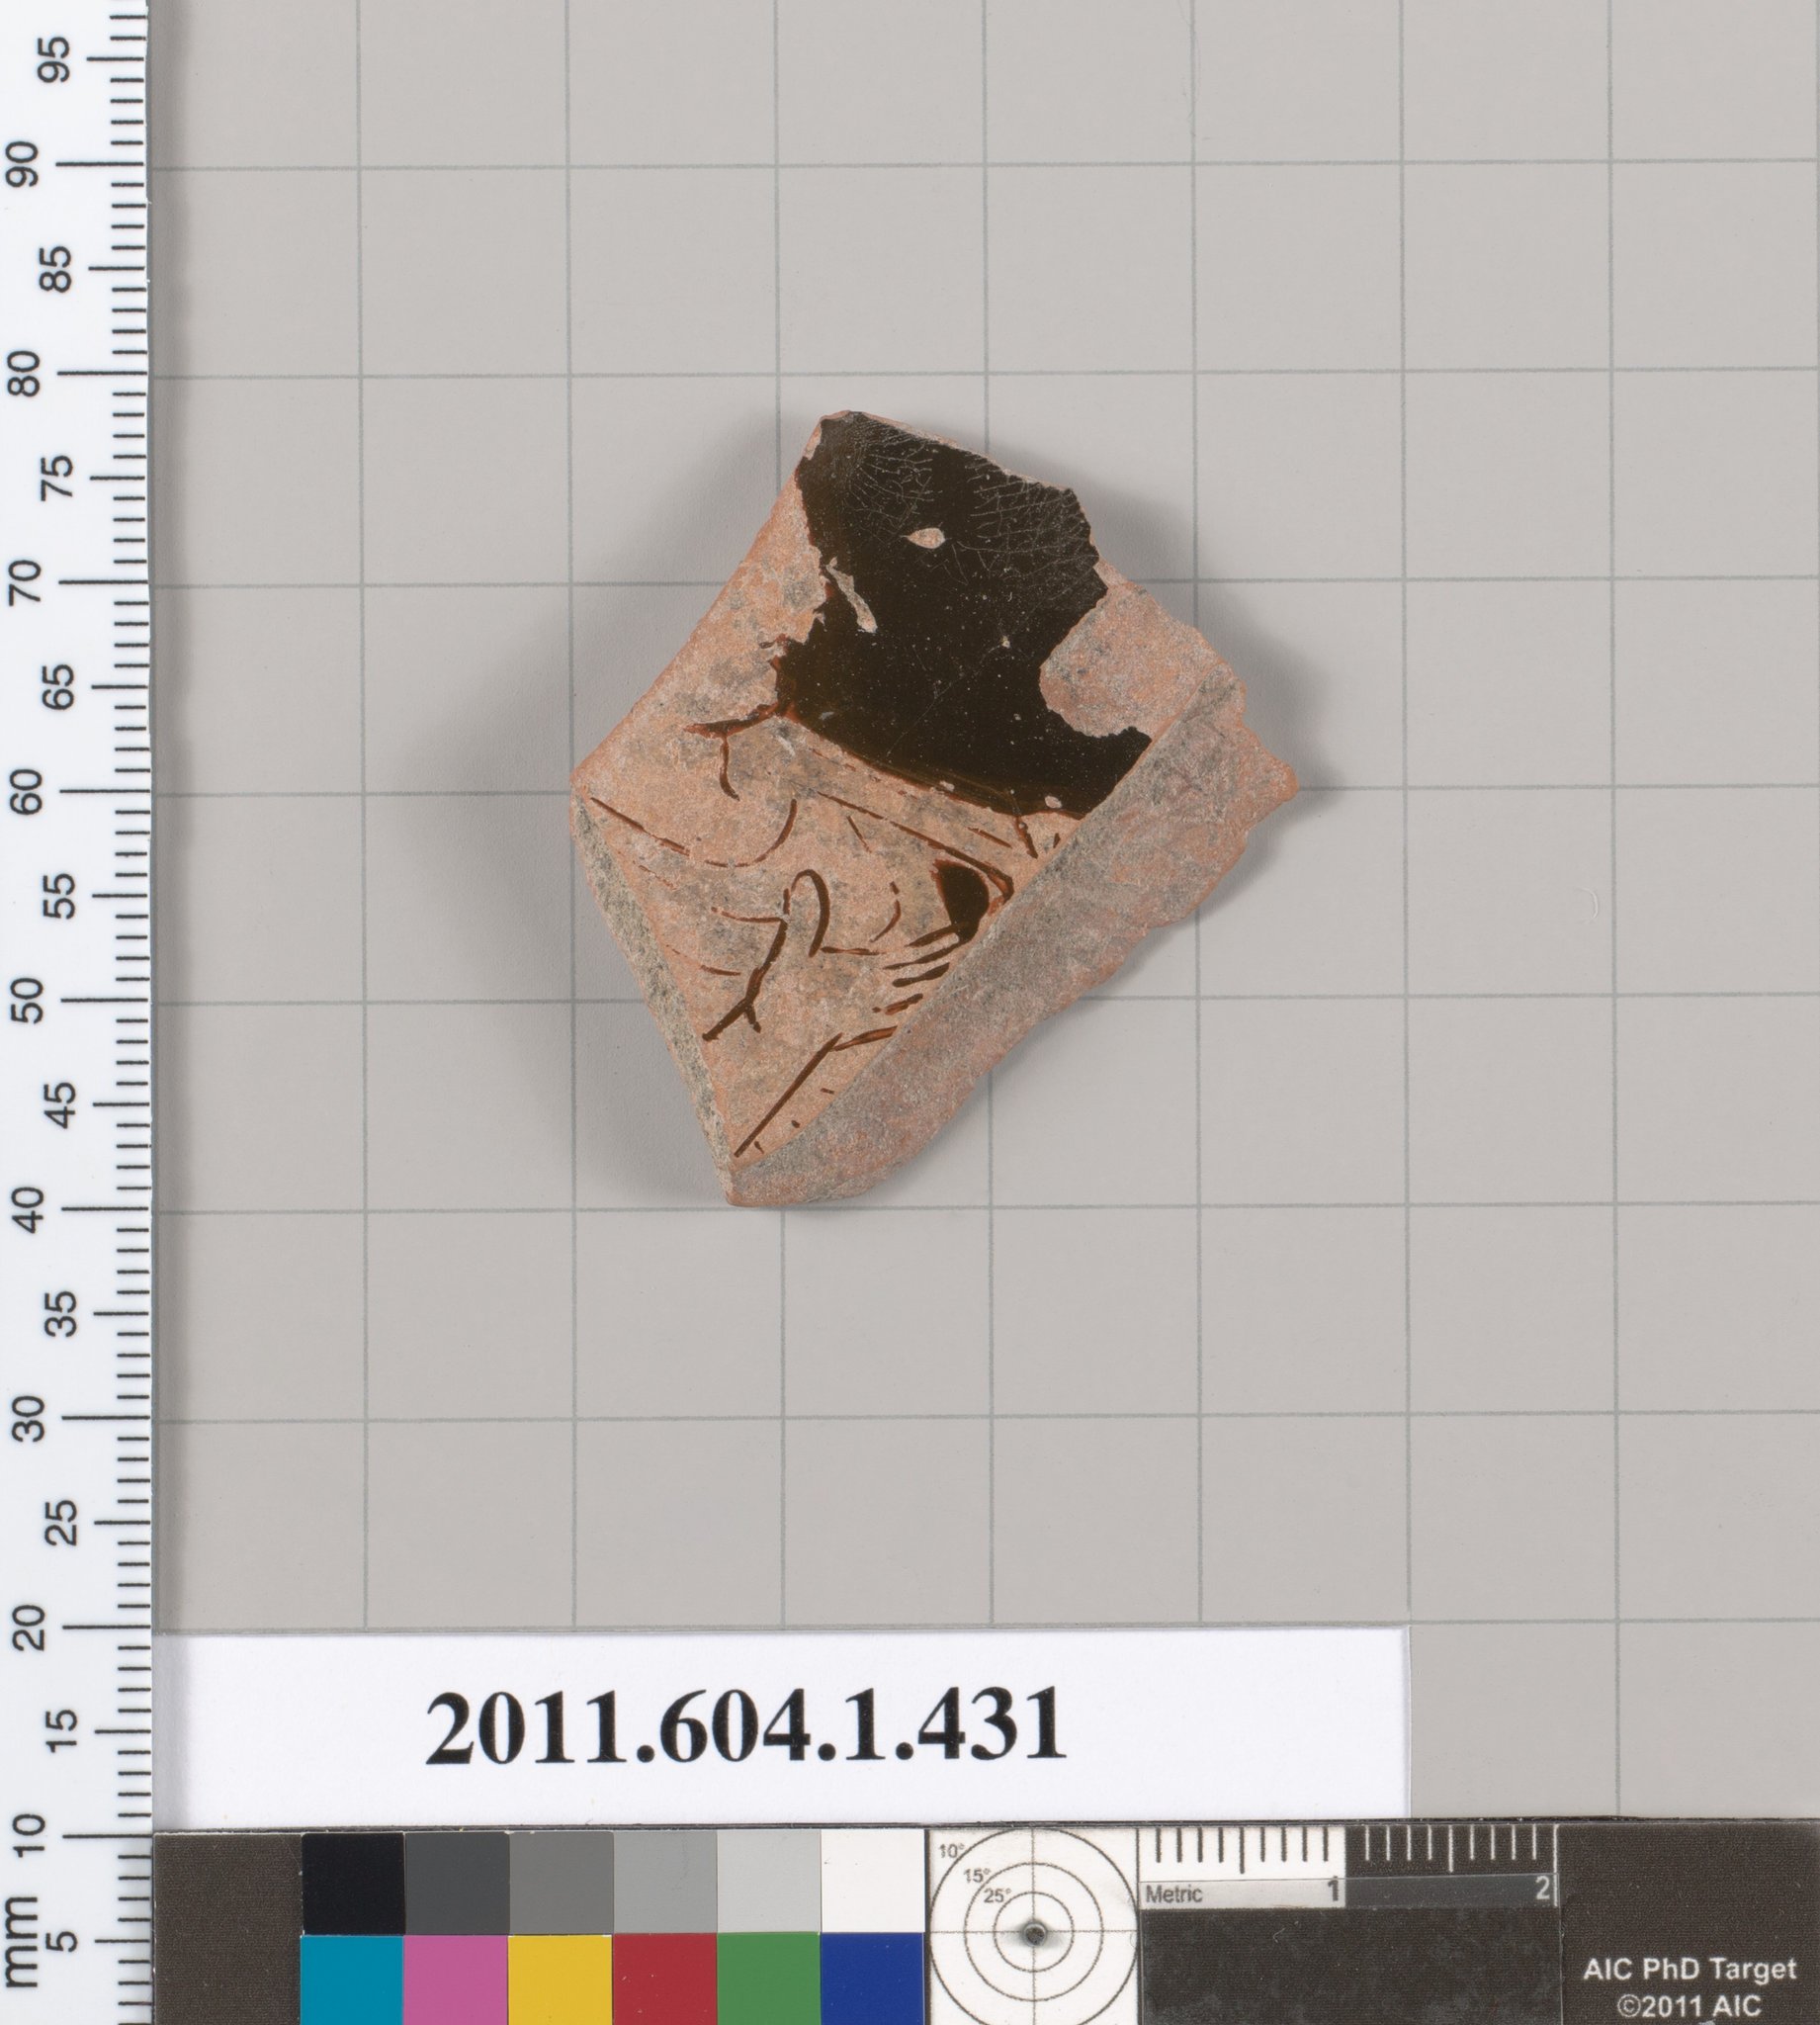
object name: kylix fragment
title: Terracotta fragment of a kylix (drinking cup)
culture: greek, attic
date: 475-451 BCE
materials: terracotta